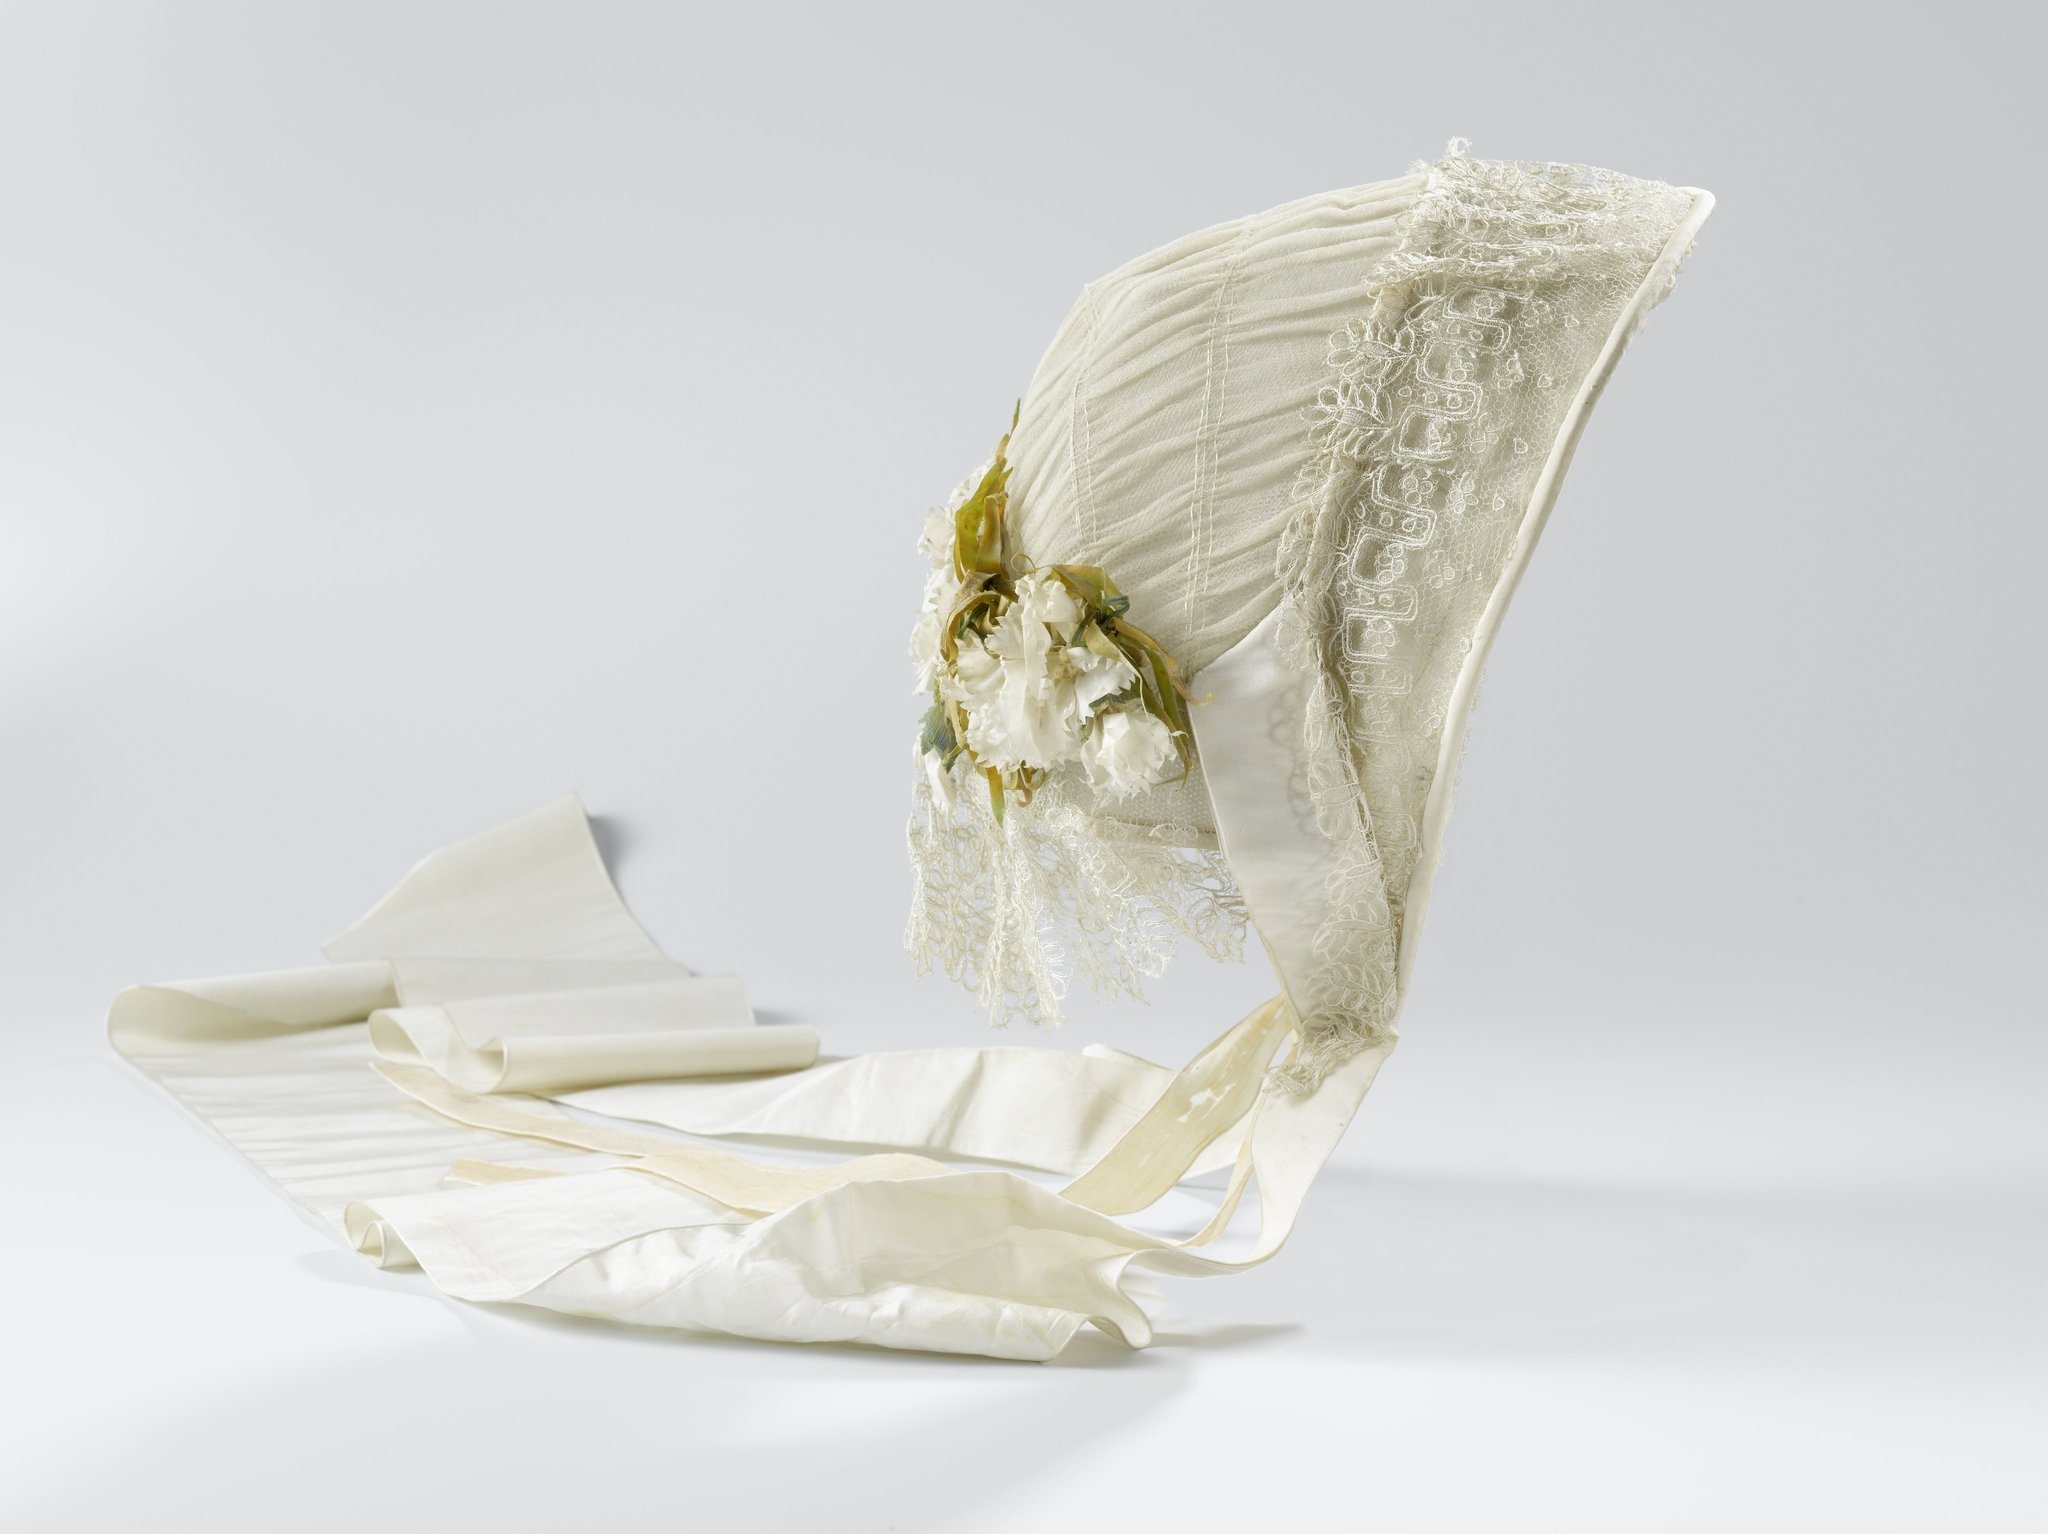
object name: womenswear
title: Luifelhoed van witte tule op grofmazig gaas, afgezet met witte ripszijde en versierd met kloskant, katoenen bloemen en satijnen lint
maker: Anonymous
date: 1855-1865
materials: textile, cotton, metal, silk, wax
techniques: lace, weave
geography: netherlands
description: Luifelhoed van witte machinale tule op grofmazig gaas, afgezet met witte ripszijde en versierd met kloskant, katoenen bloemen en satijnen lint. Model: kap van grofmazig tule verstevigd met laitondraad en baleinen. Rondom afgezet met ripslint. Zowel binnen als buiten bekleed met crêpe georgette, die aan de buitenkant gerimpeld over de kap is aangebracht. Versiering: 'bavolette' (strook in de nek) van ... Anjerachtige bloemen met chenille meeldraden en kelk van groene was. Striklinten van satijn.